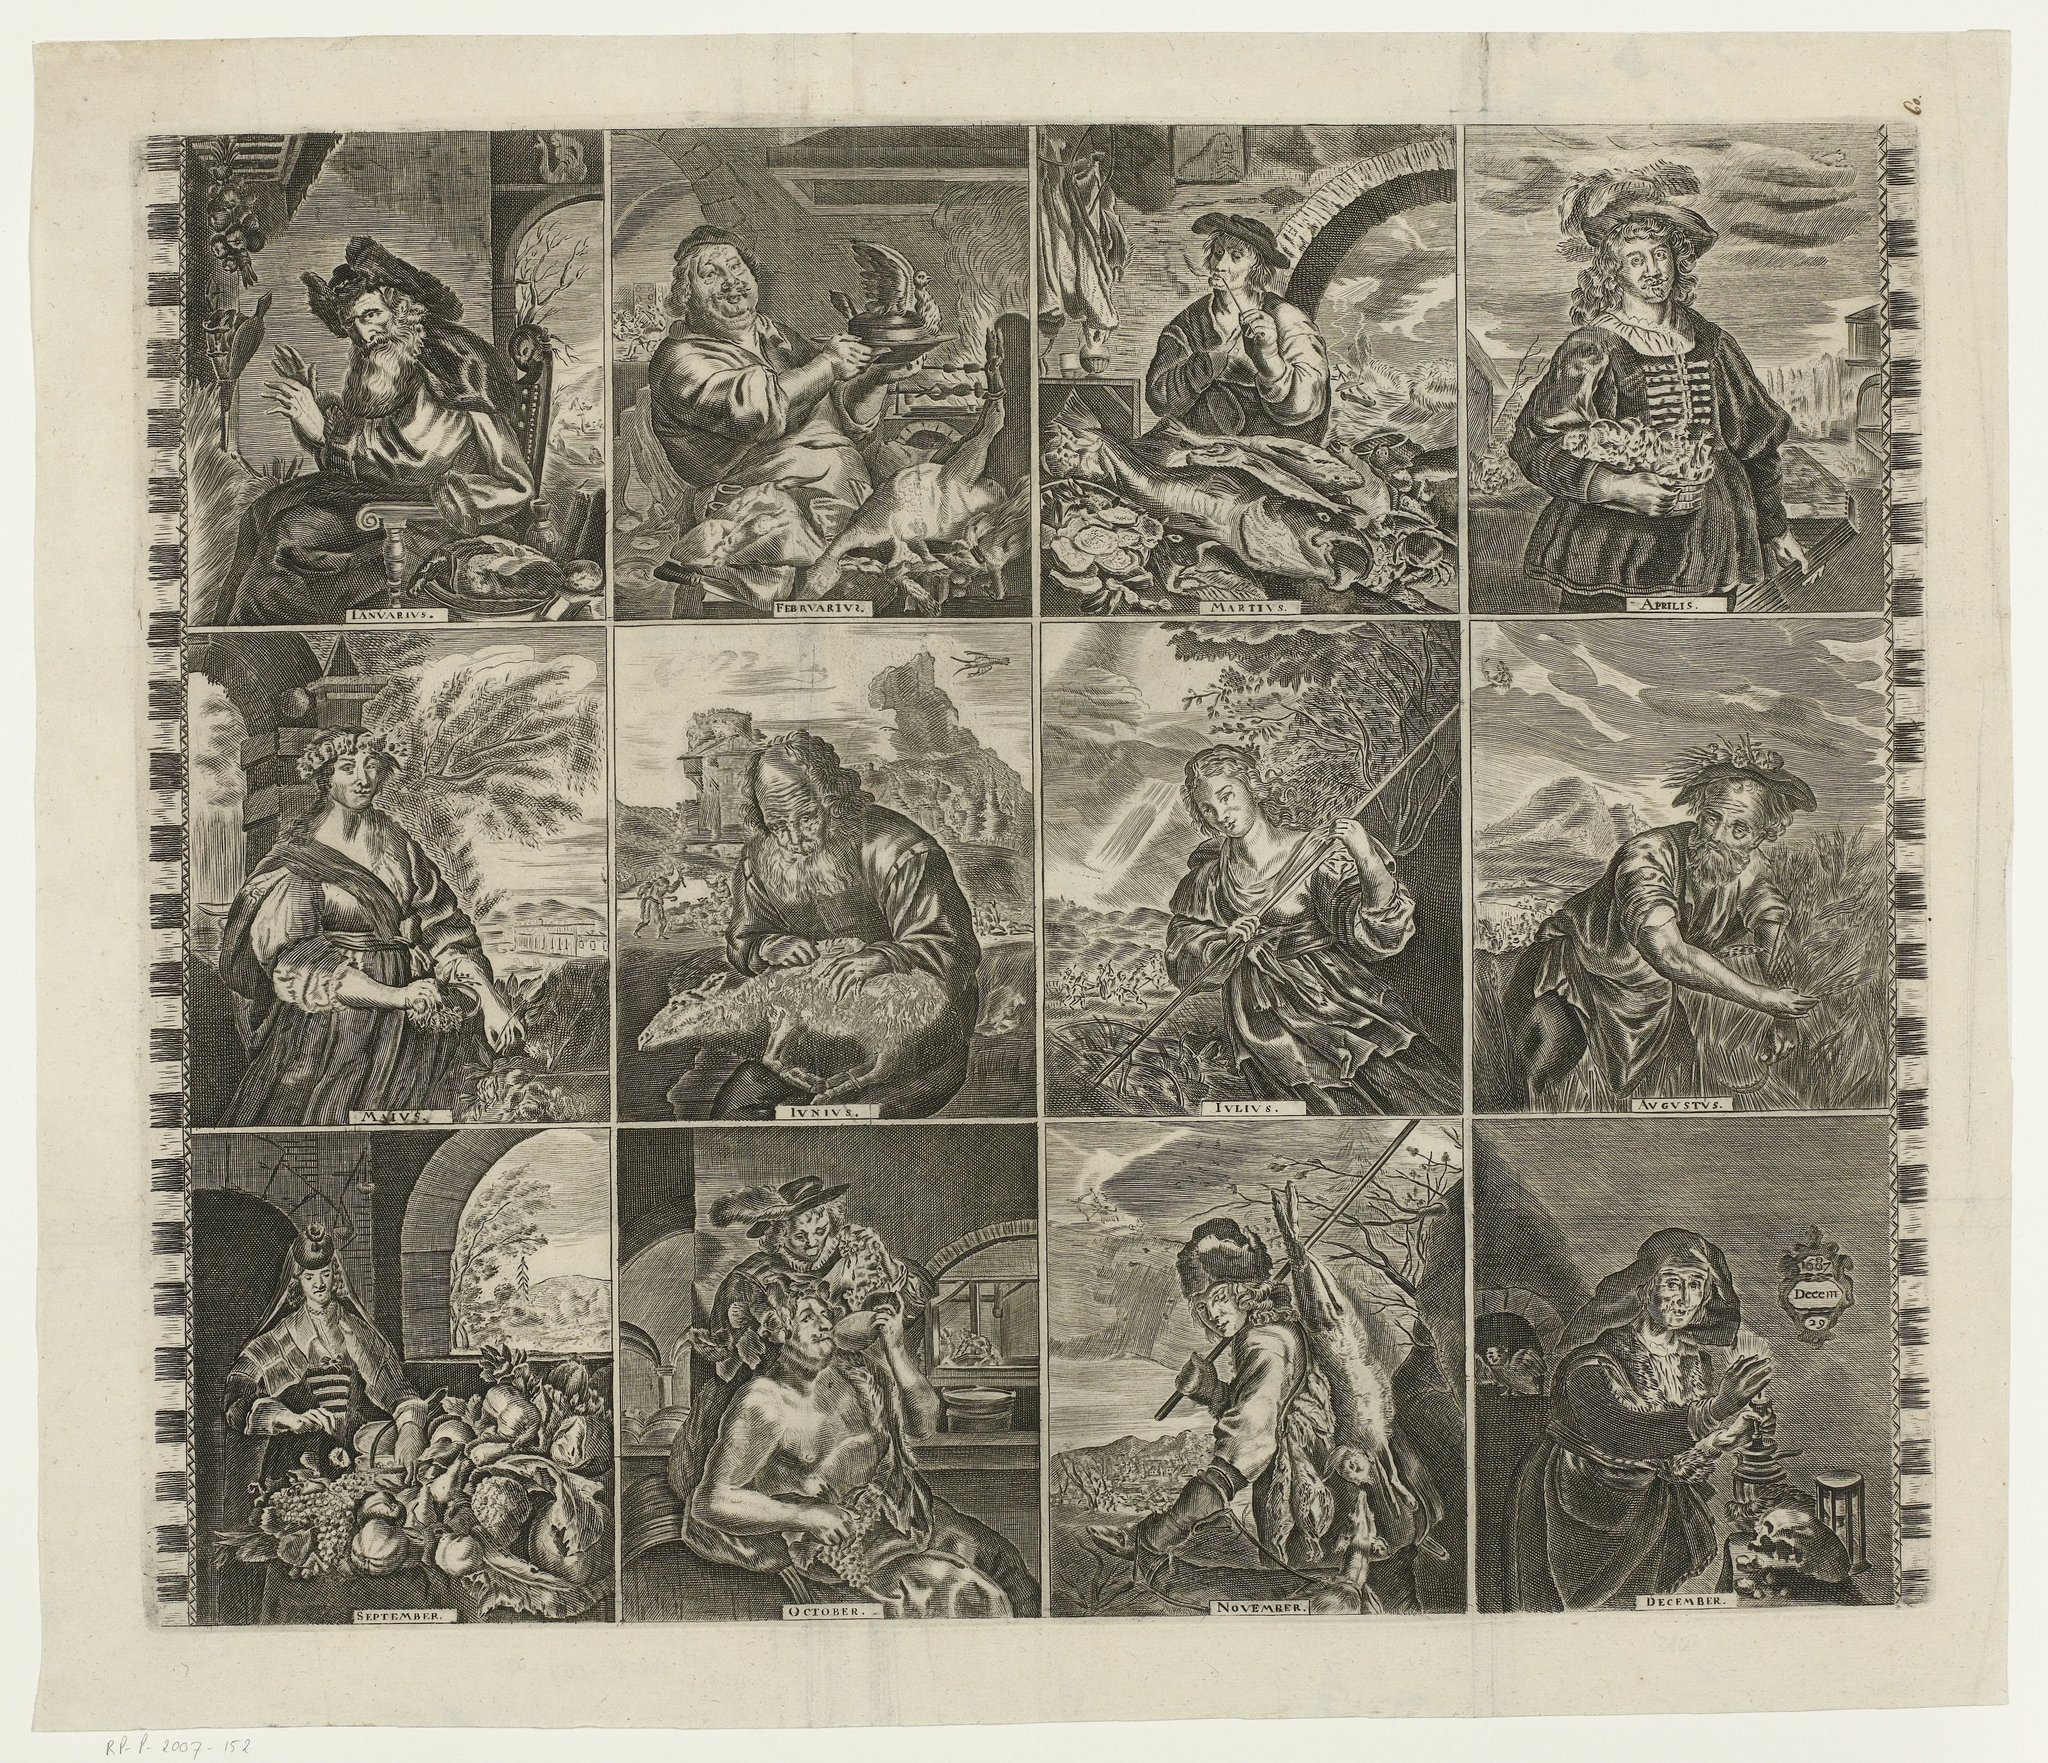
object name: print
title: De twaalf maanden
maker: Anonymous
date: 1687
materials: paper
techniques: engraving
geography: netherlands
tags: the twelve months represented by scenes showing human activities, usually in a landscape; so-called 'labours of the months' (+ with zodiacal signs)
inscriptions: collector's mark: Lugt 2228, collector's mark: Lugt 2760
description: De twaalf maanden van het jaar verbeeld door menselijke bezigheden. Op de bovenste rij de maanden januari tot en met april, op de middelste rij de maanden mei tot en met augustus en op de onderste rij de maanden september tot en met december.